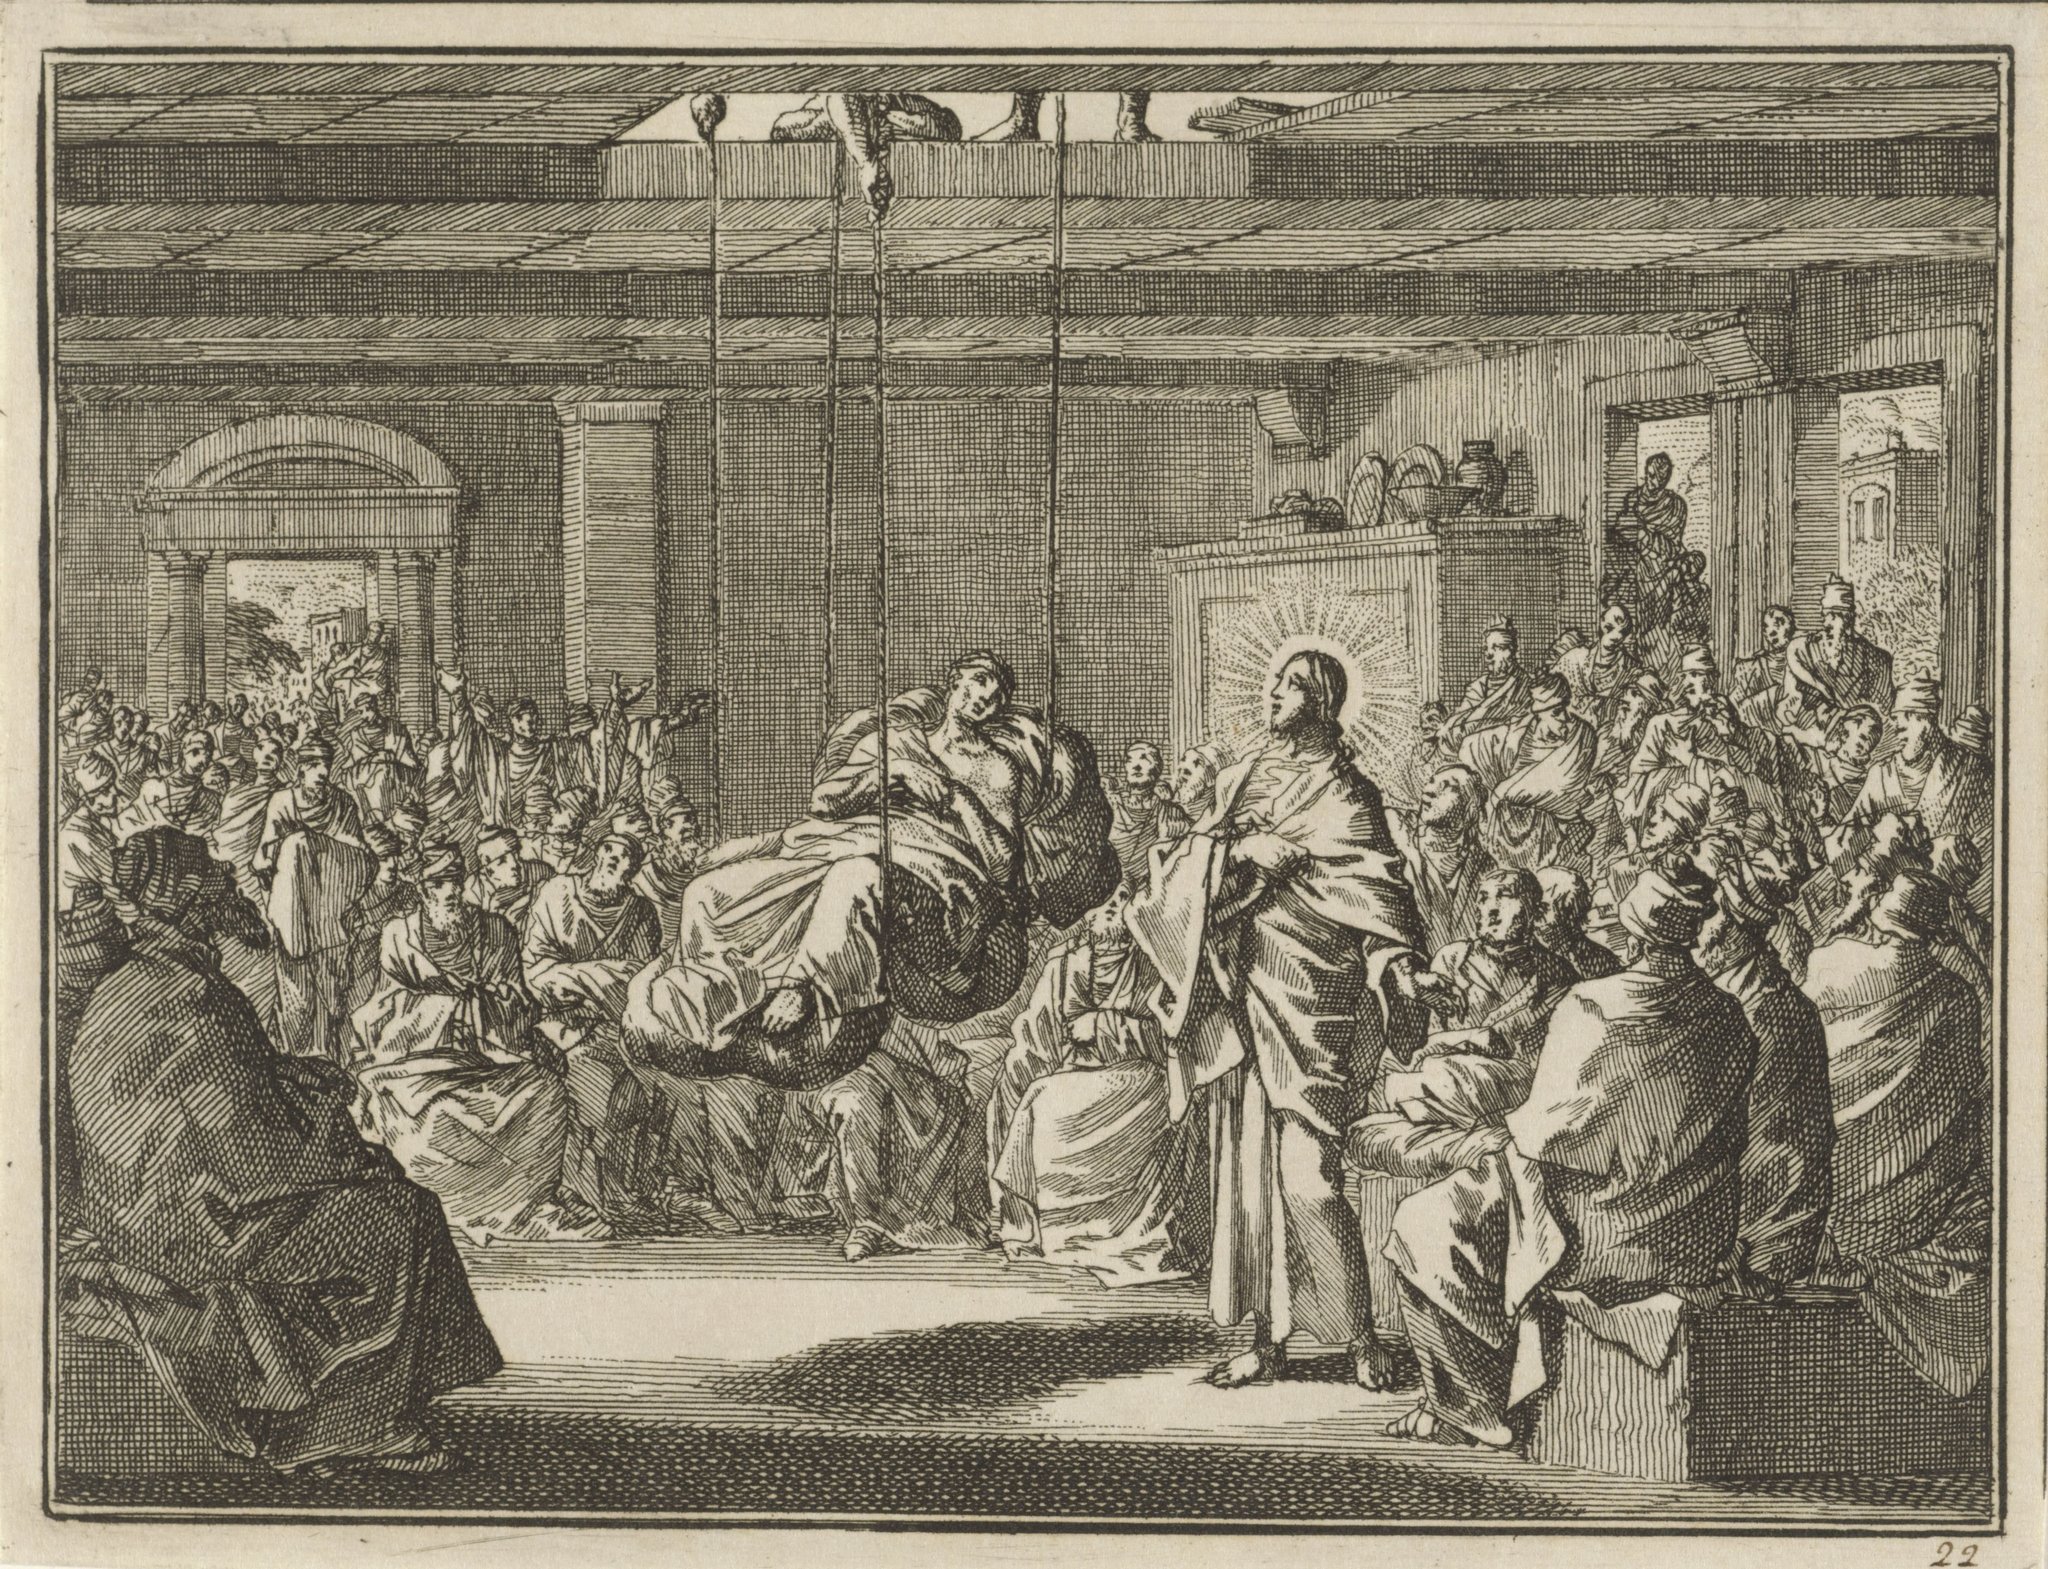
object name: print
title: Genezing van een verlamde die door het dak naar beneden wordt gelaten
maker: jan luyken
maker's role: draughtsman, print maker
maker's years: 1649-1712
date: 1712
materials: paper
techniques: etching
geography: amsterdam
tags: a paralytic is let down through the roof of the house where christ is preaching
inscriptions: number: ‘22’, collector's mark: Lugt 2228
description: Proefdruk van illustratie uit: Luyken, Jan. De schriftuurlyke geschiedenissen en gelykenissen van het Oude en Nieuwe Verbond, 2 delen. Amsterdam: Wed. Pieter Arentsz II en Cornelis van der Sys, 1712, dl. II.